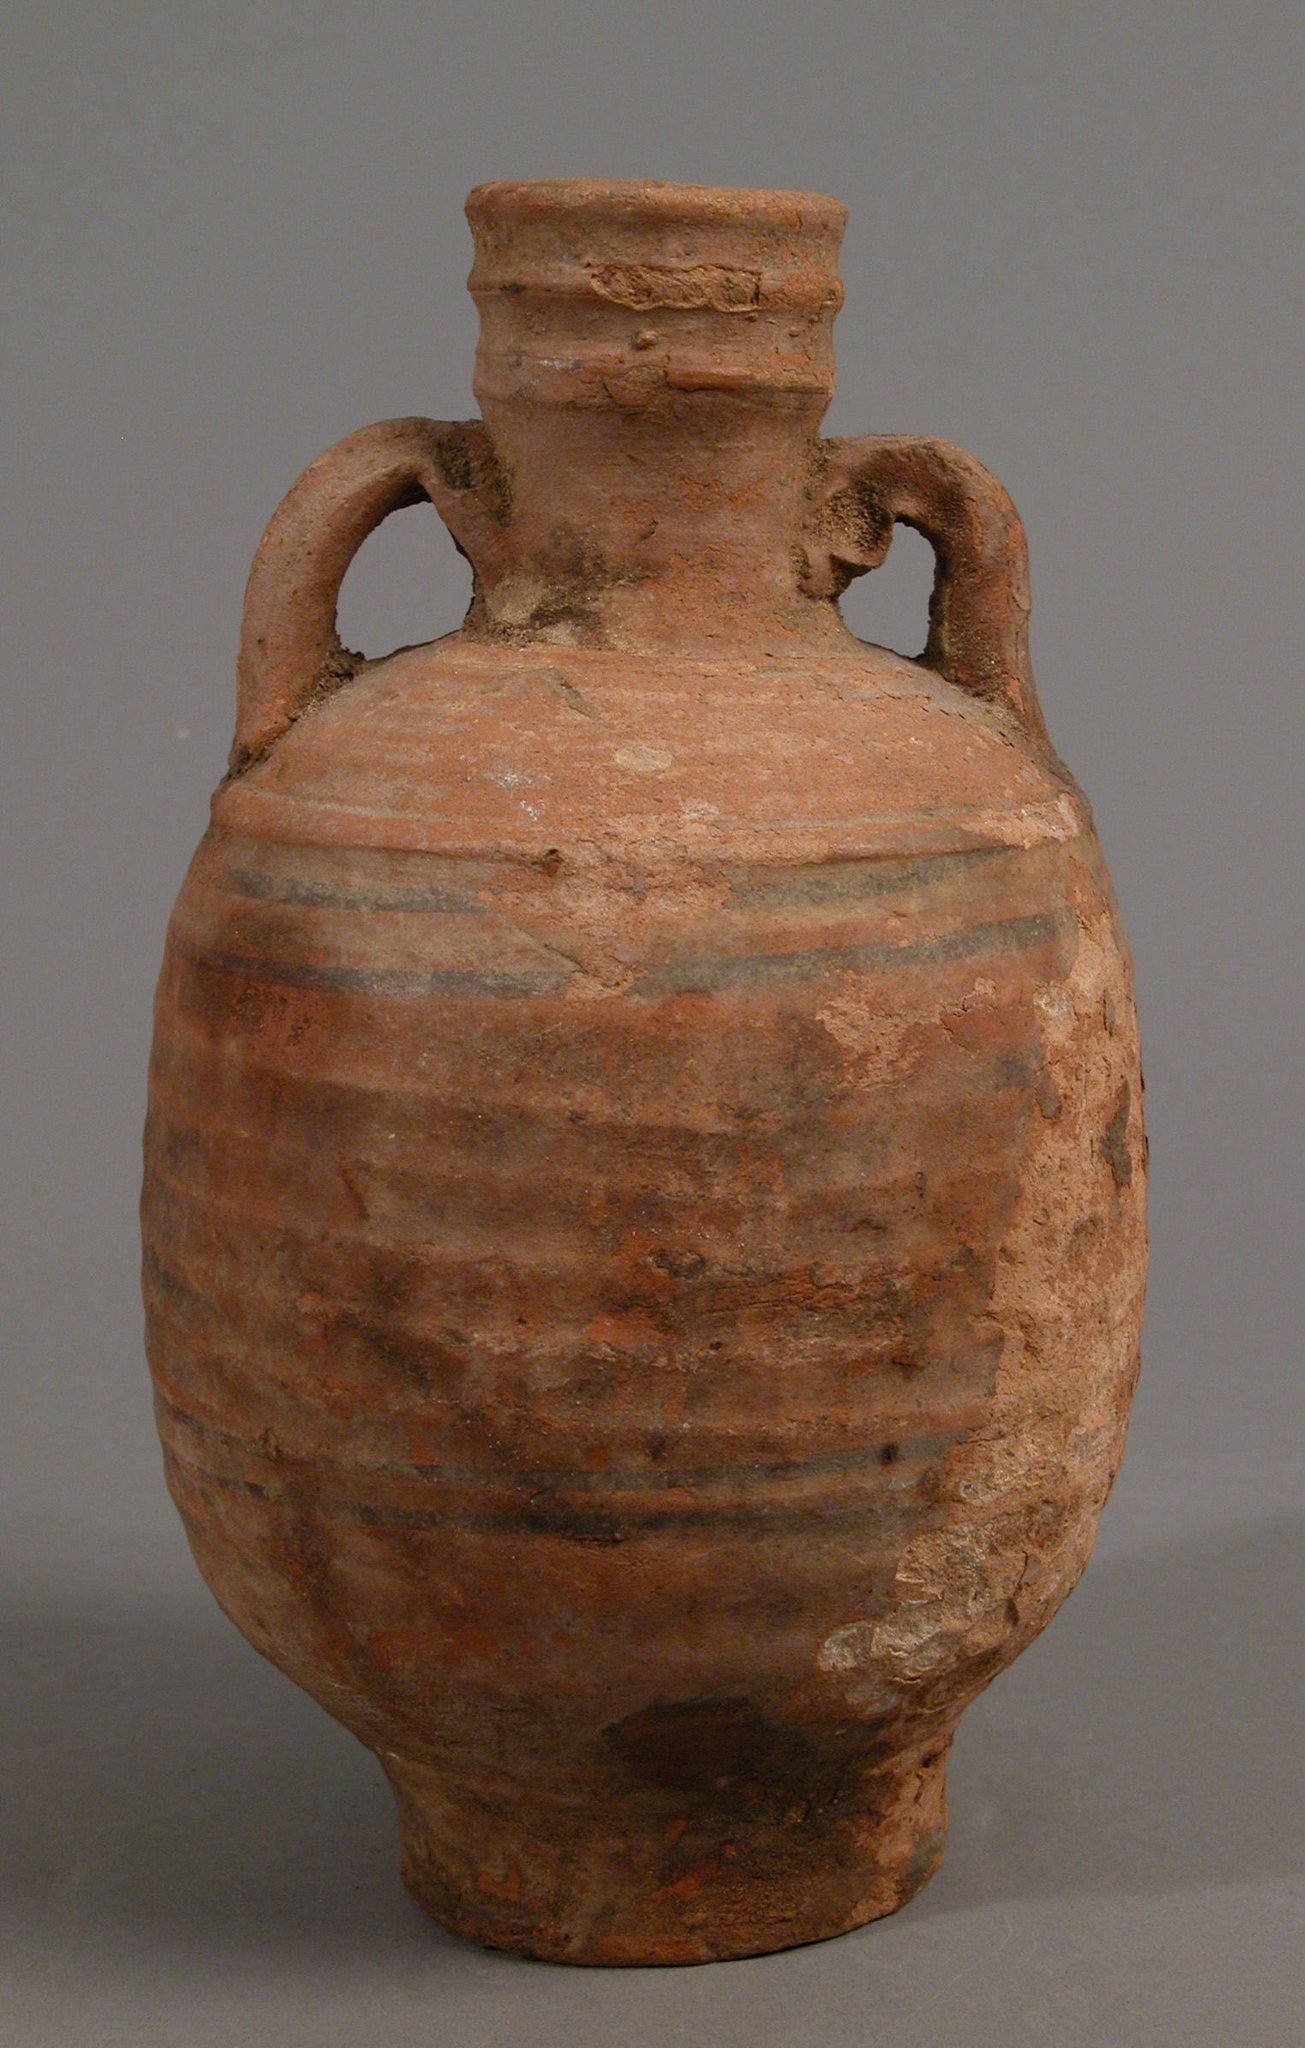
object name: pot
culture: coptic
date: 301-700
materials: earthenware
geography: egypt